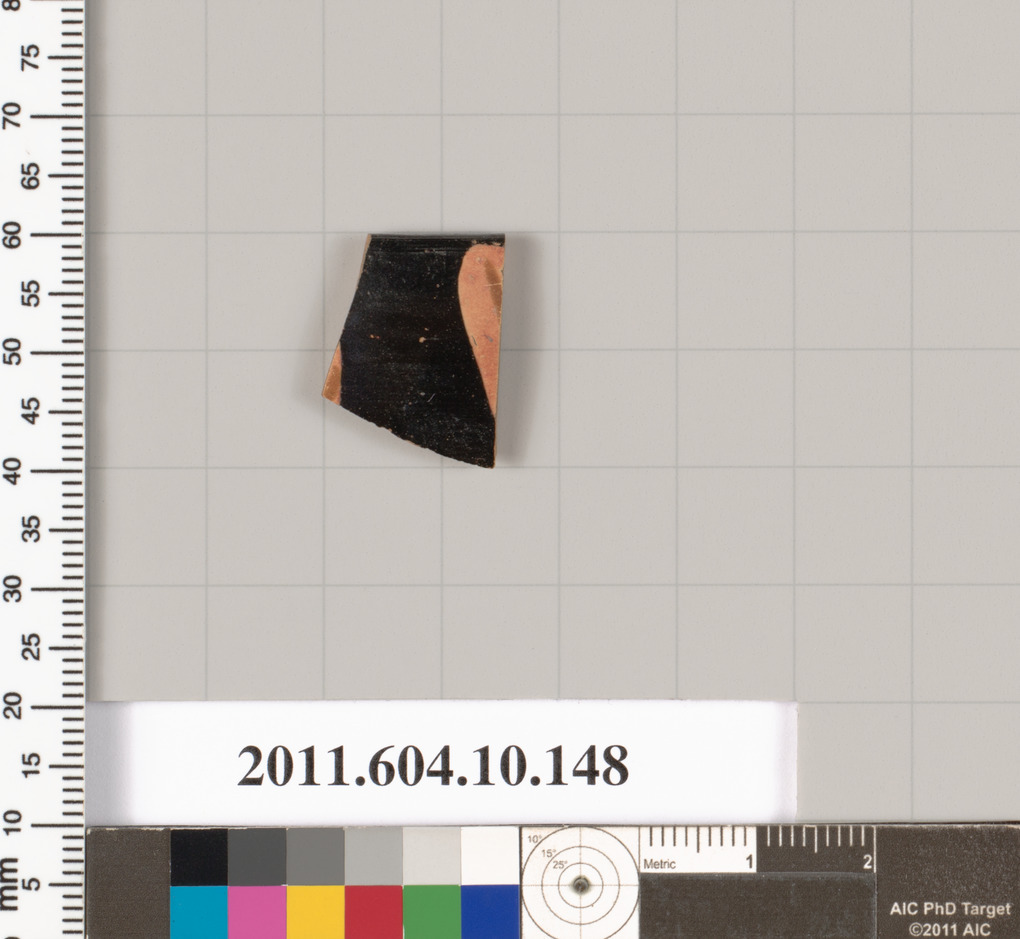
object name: skyphos fragment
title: Terracotta rim fragment of a skyphos (deep drinking cup)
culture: etruscan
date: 434-401 BCE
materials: terracotta